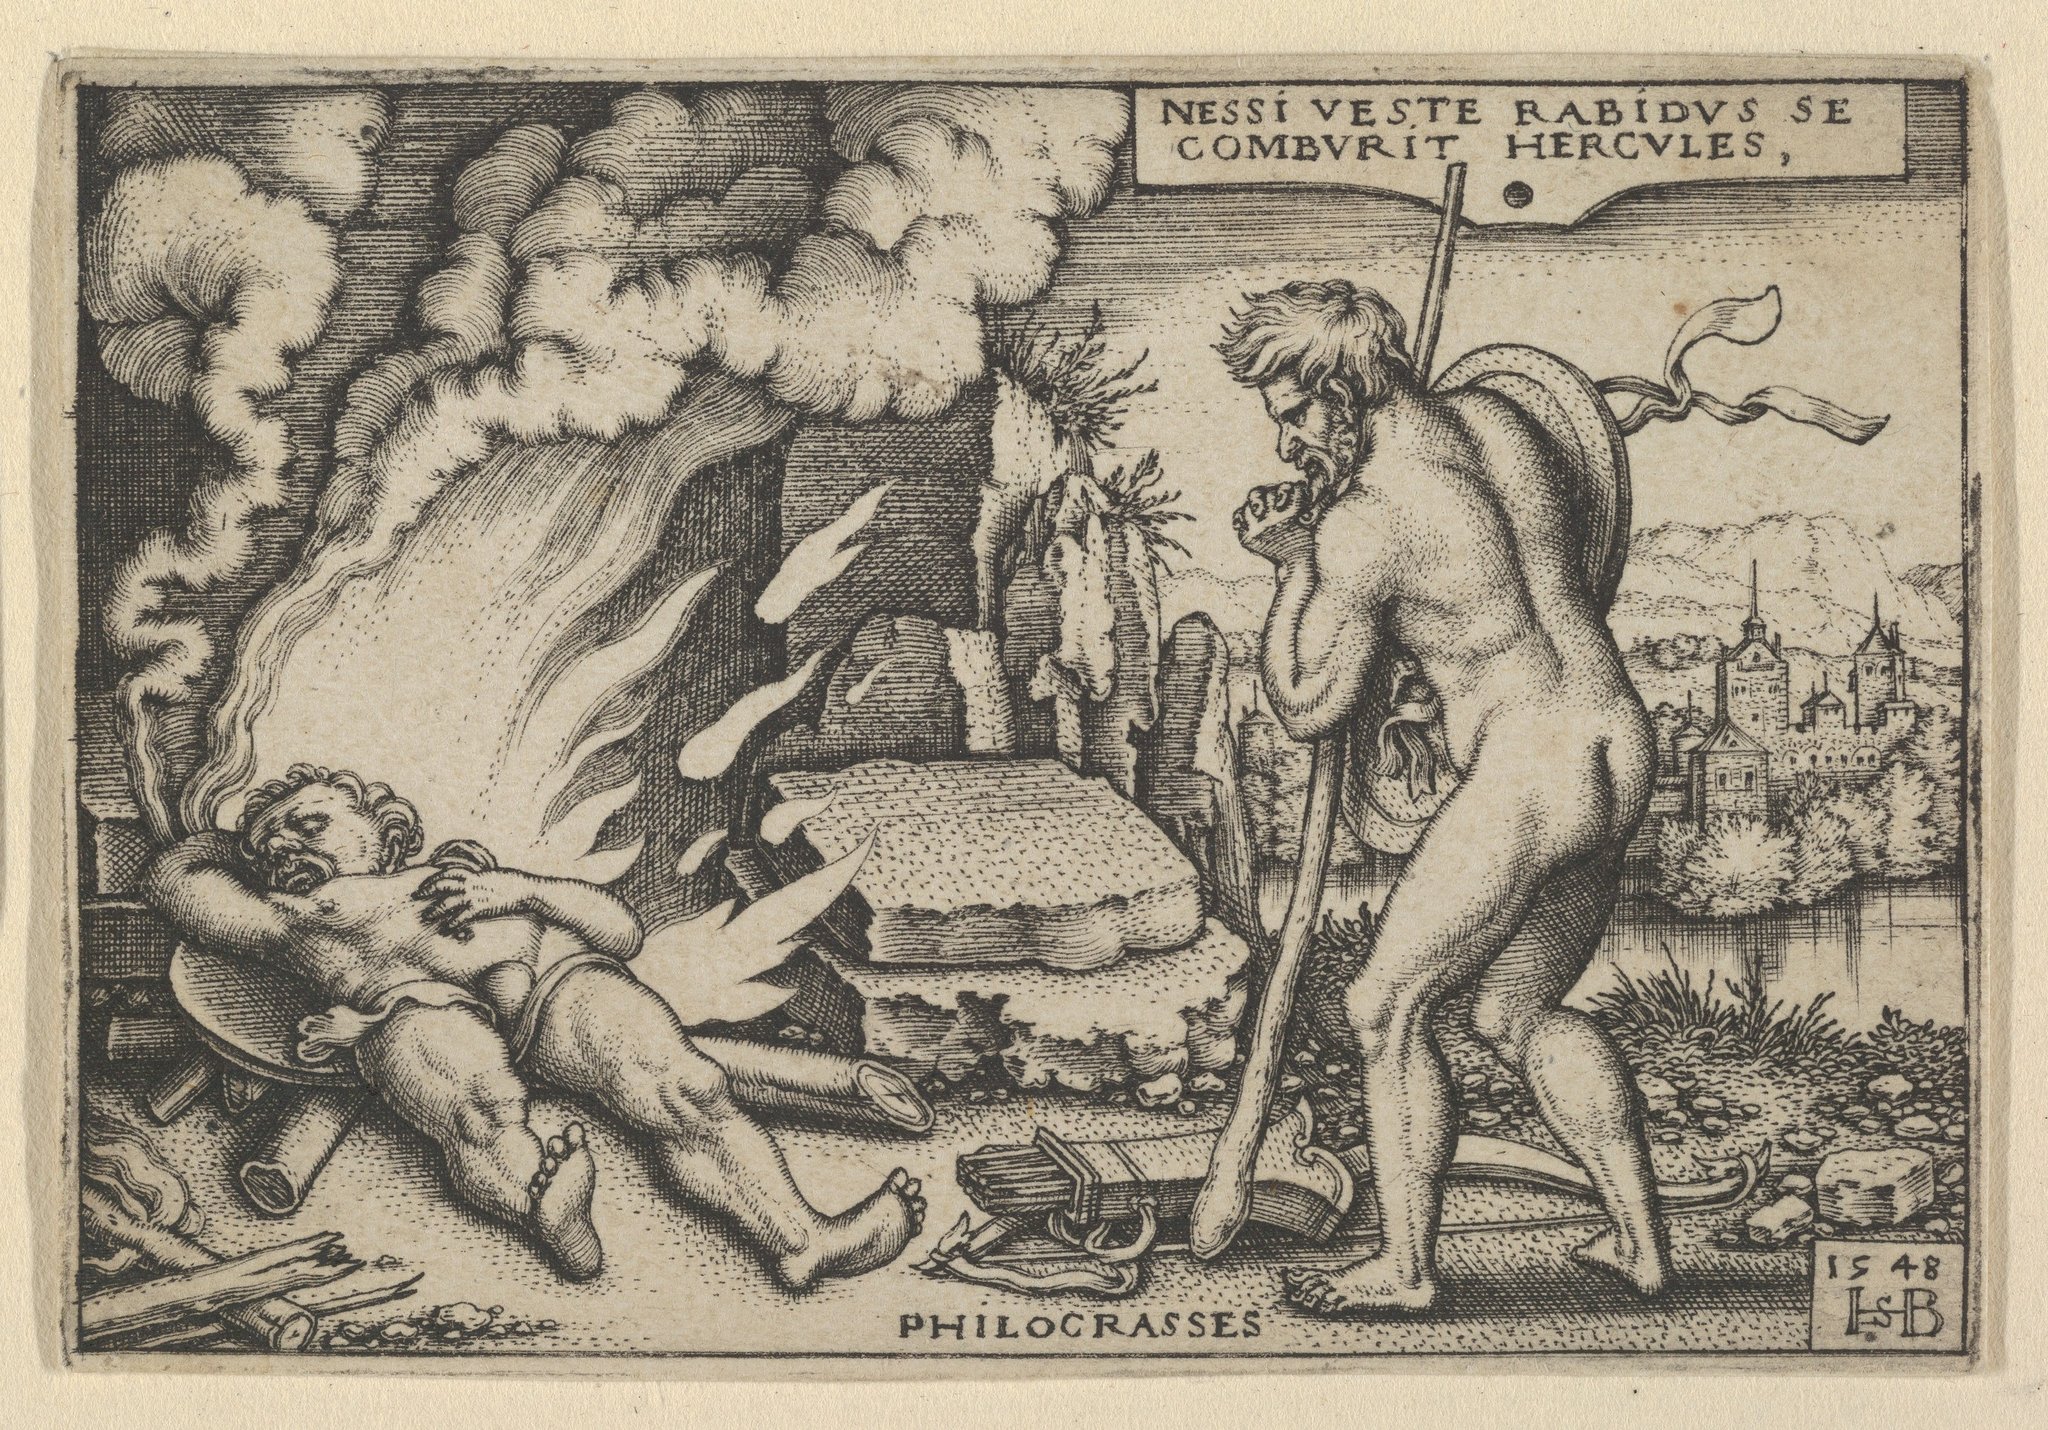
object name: print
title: The Death of Hercules, from "The Labors of Hercules"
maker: sebald beham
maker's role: artist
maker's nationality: german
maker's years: 1500-1550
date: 1500-1550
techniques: engraving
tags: hercules,death